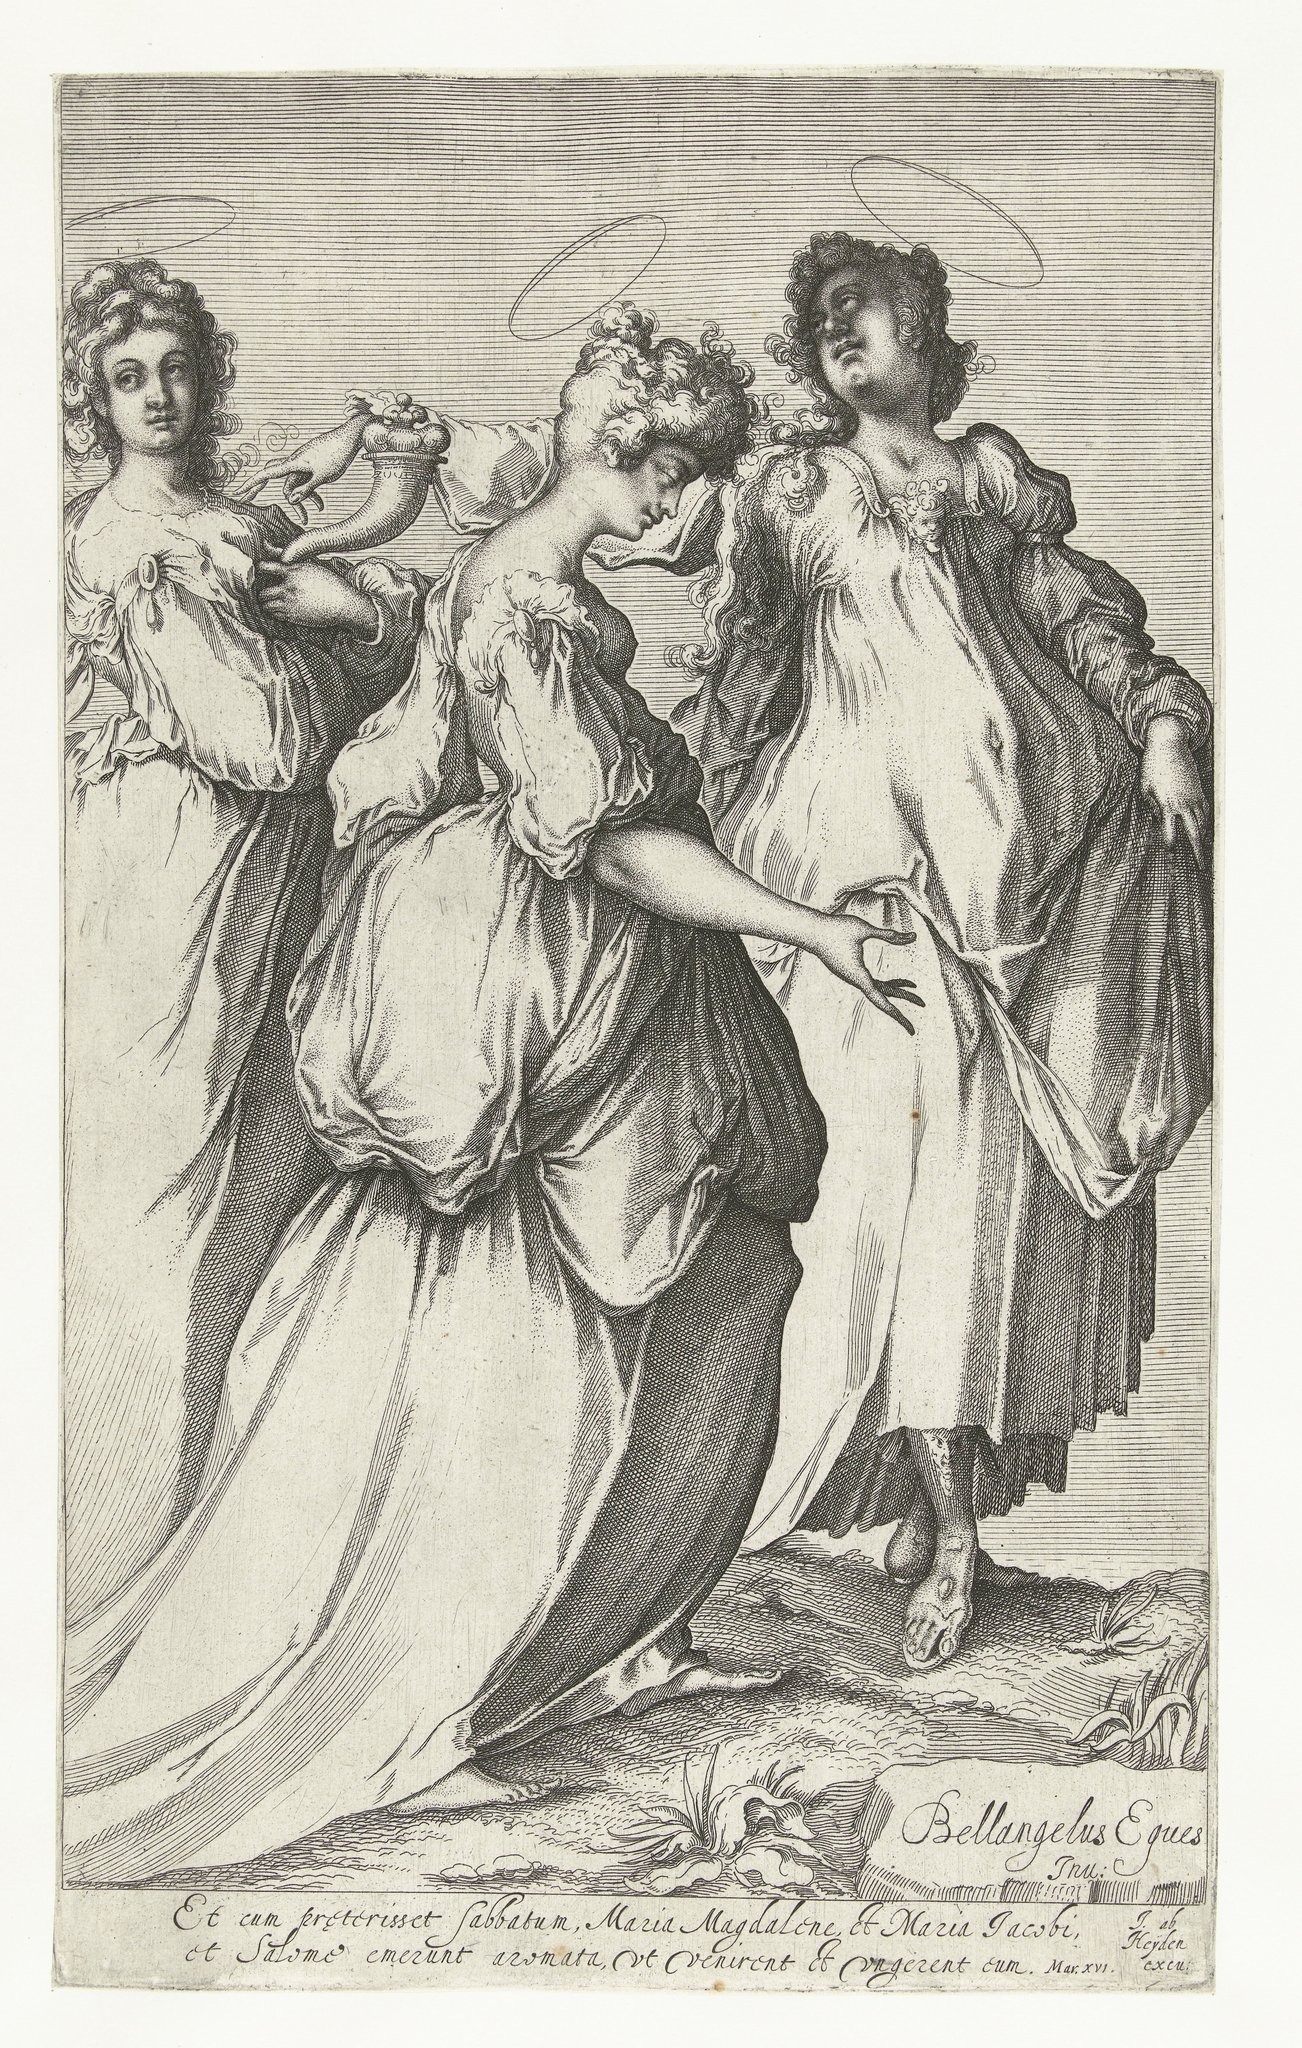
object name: print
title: Drie heilige vrouwen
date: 1603-1650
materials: paper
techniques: etching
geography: straatsburg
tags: the holy women (the three maries) on their way to or at the tomb, to anoint christ's body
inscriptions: collector's mark: Lugt 240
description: Maria Magdalena, Maria Jacobi en Maria Salomé op weg naar het graf van Christus. Onder de voorstelling een tweeregelige tekst in het Latijn.